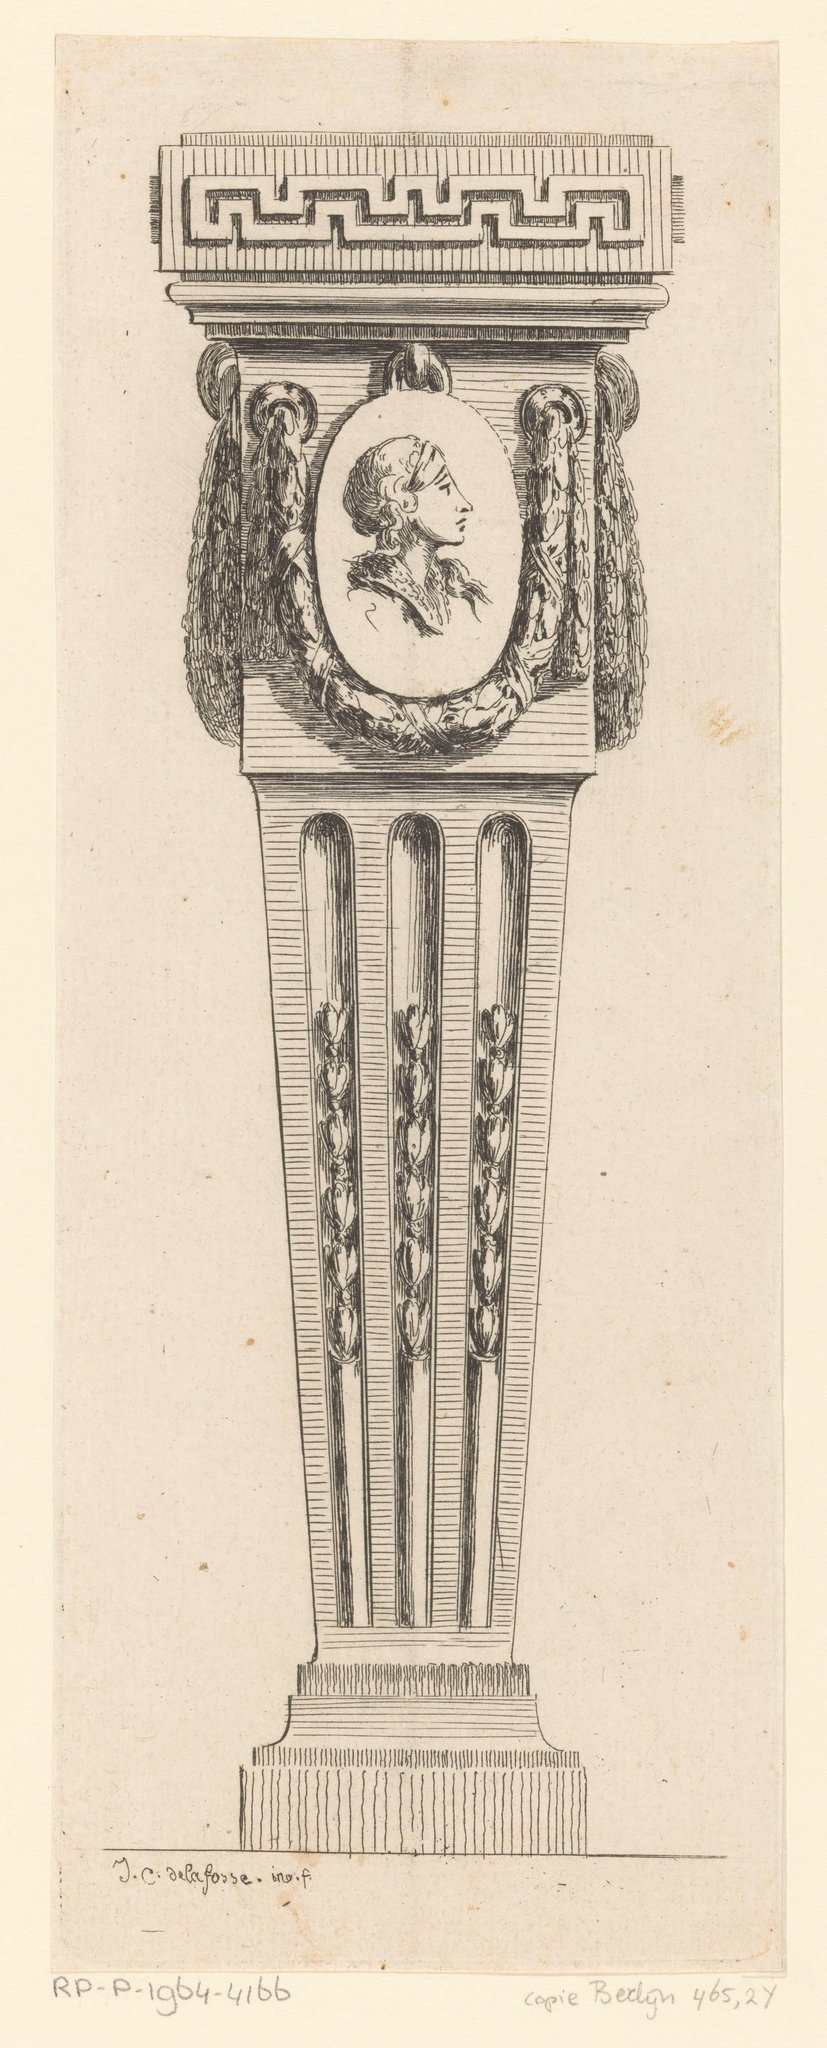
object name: print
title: Voetstuk met medaillon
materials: paper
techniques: etching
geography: france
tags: ornament ~ medallion, pedestal of a piece of sculpture (perhaps in the form of a herm)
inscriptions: collector's mark: Lugt 2228, collector's mark: Lugt 2760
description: Een geornamenteerd voetstuk met guirlandes een een ovaal medaillon met vrouwenportret en profil.